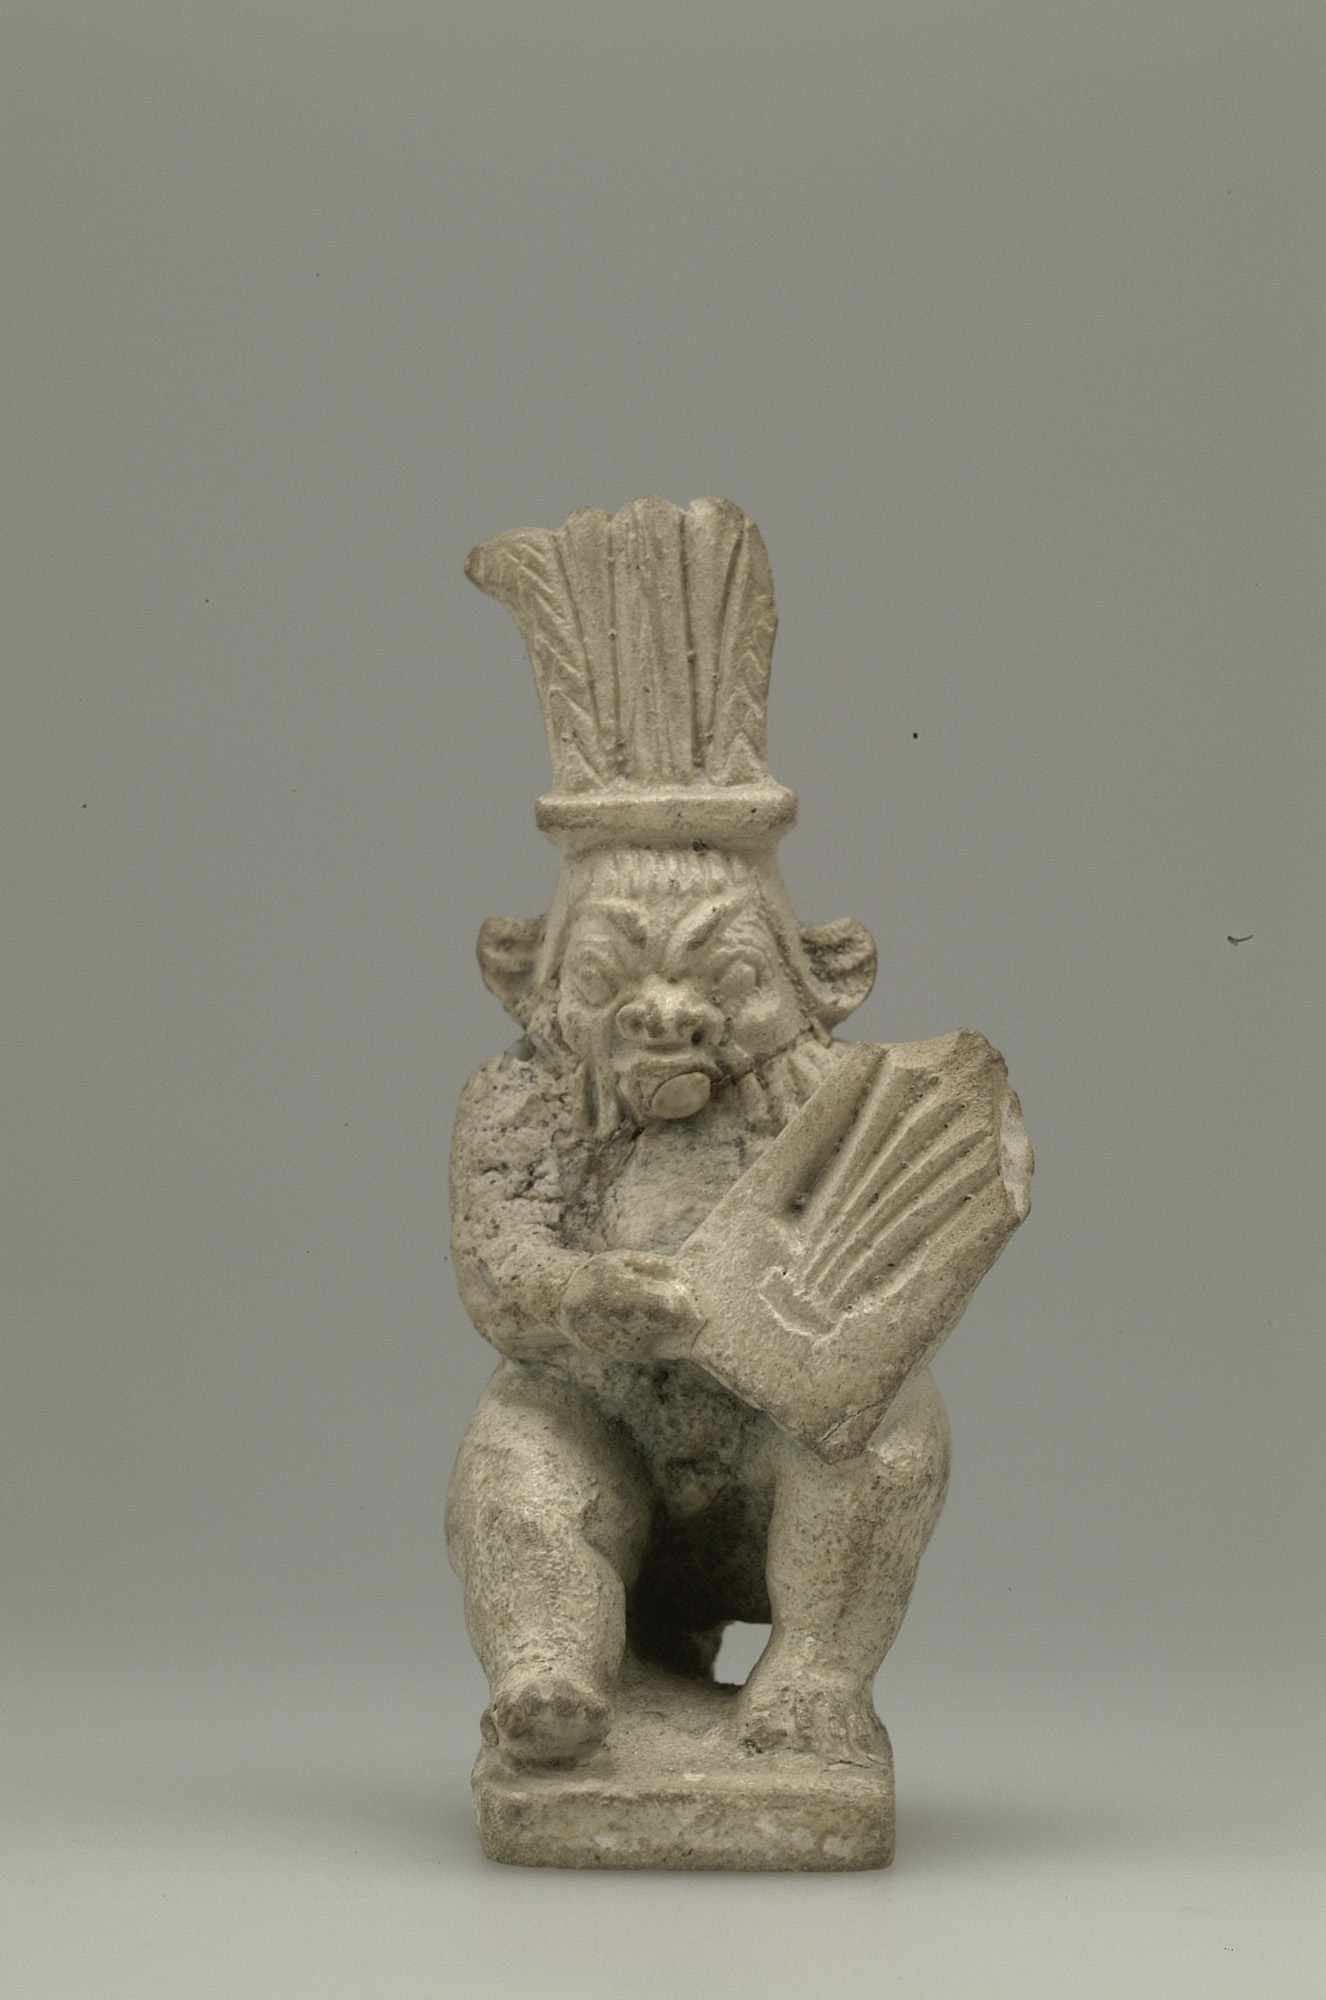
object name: amulet, be, lyre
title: Bes Amulet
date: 664-332 BCE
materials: faience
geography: egypt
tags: bes